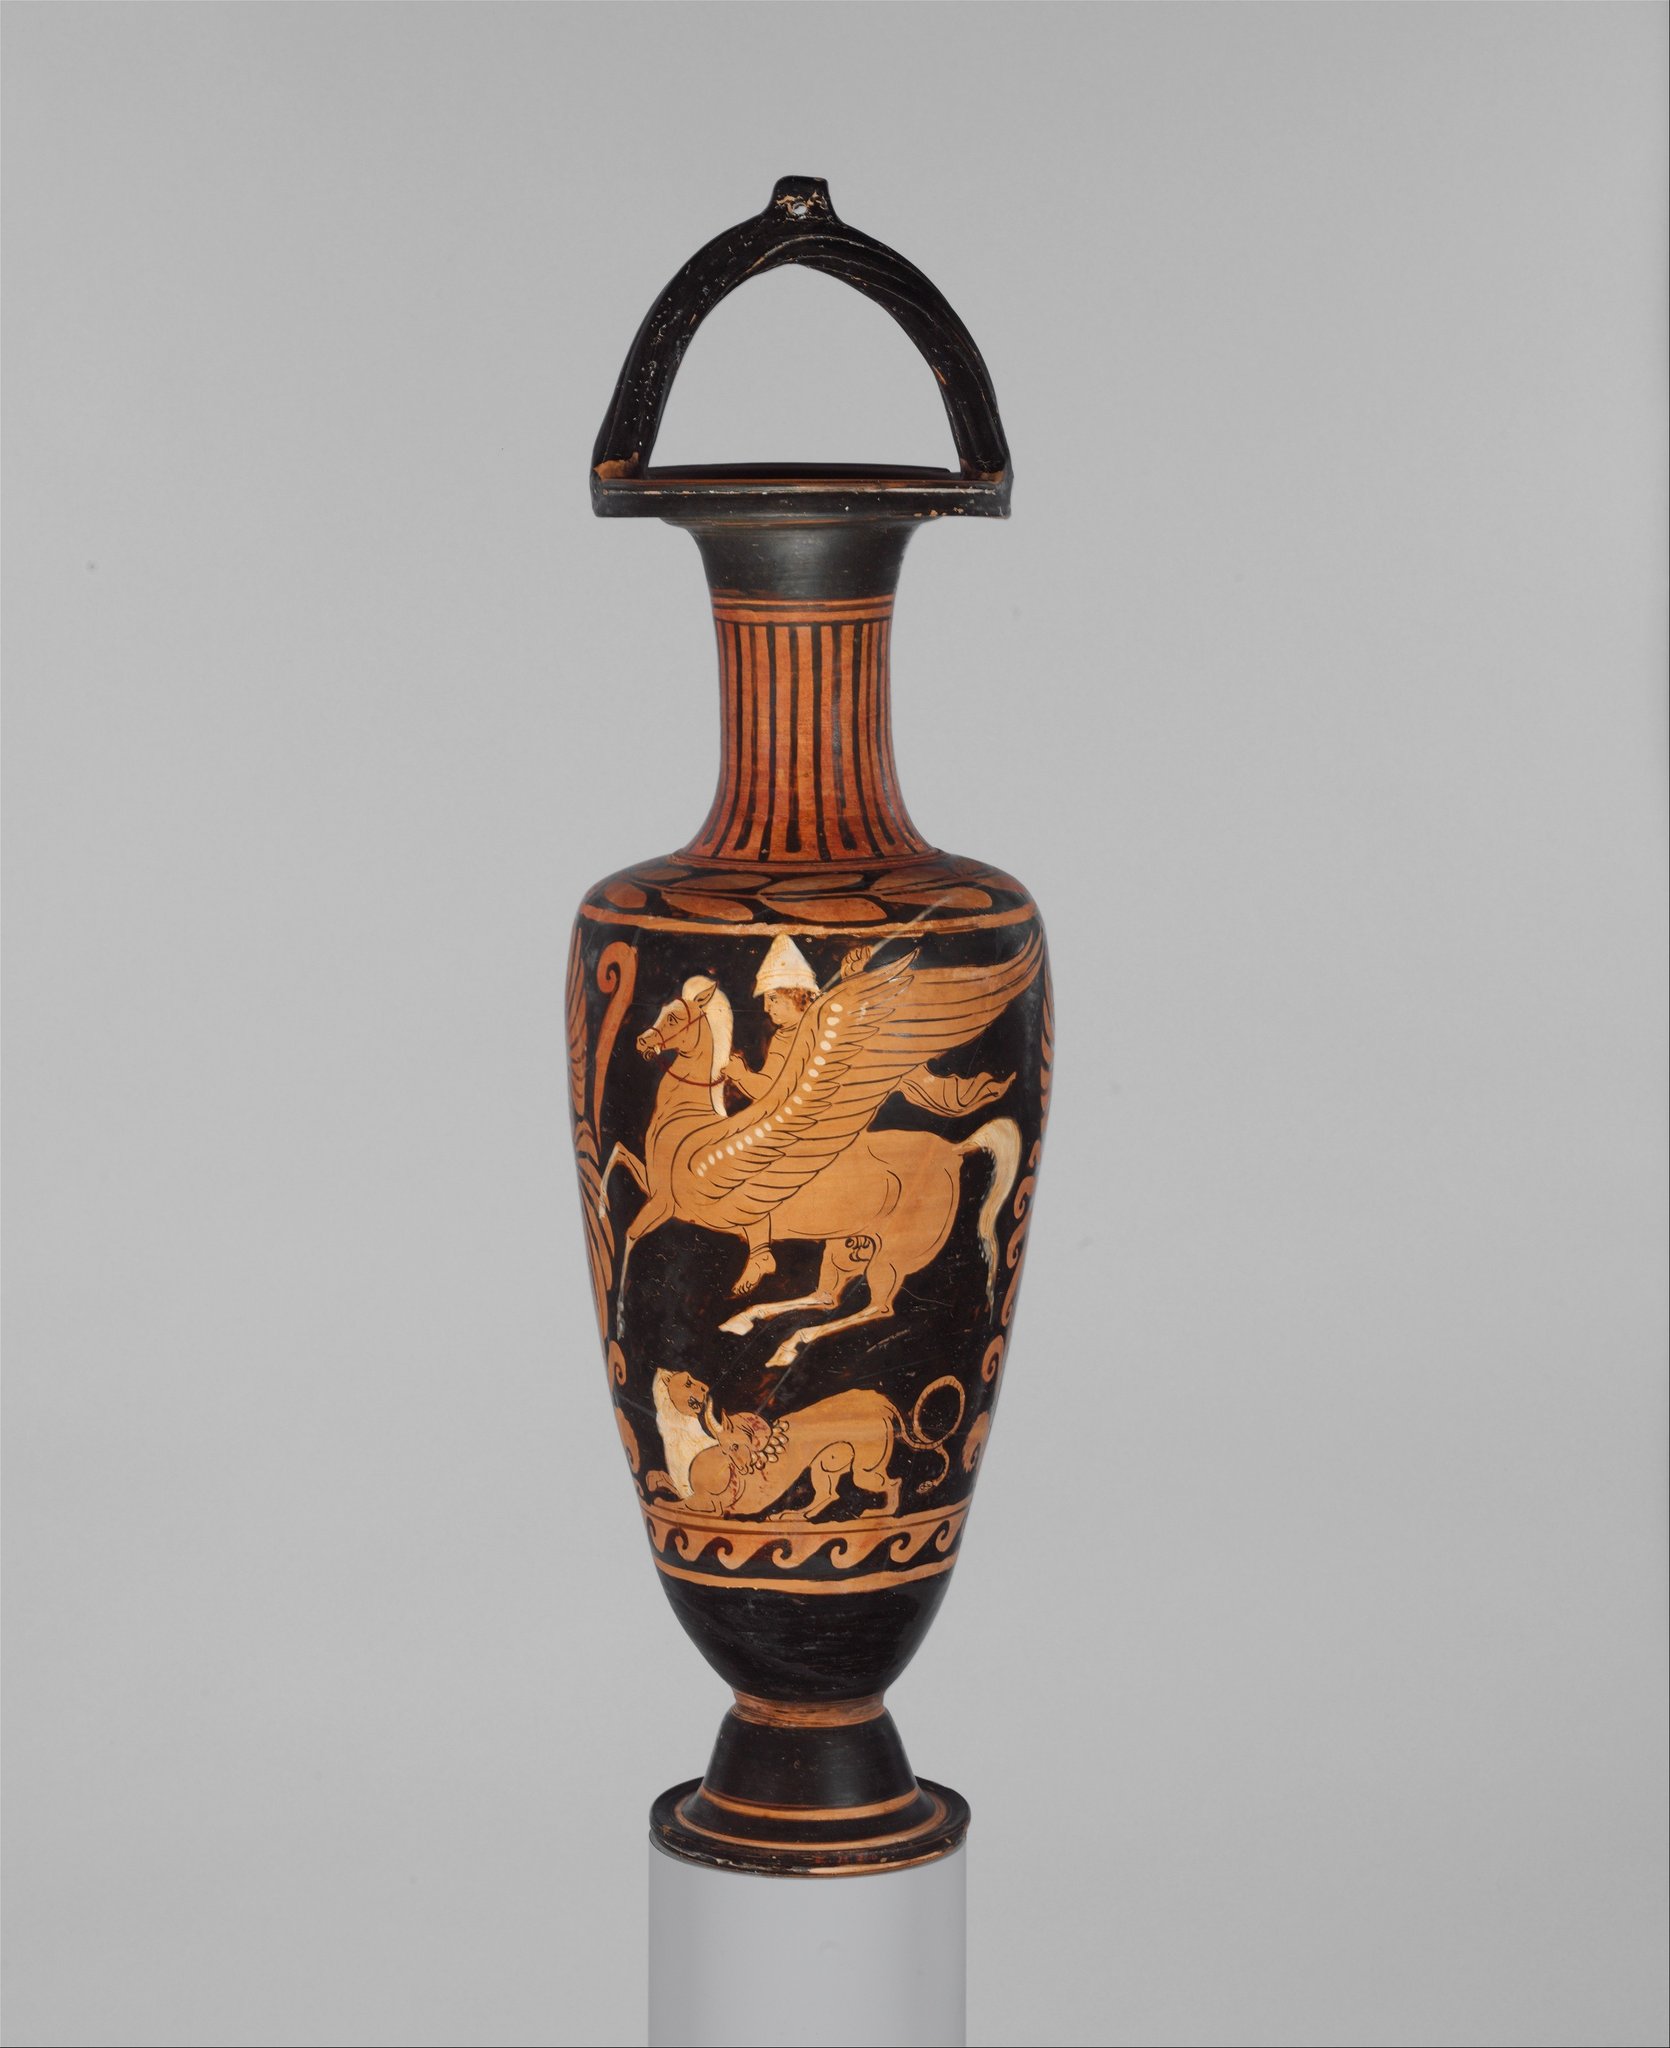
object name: bail amphora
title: Terracotta bail-amphora (jar)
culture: greek or south italian or campanian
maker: ixion painter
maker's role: artist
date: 330-310 BCE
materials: terracotta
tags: men,pegasus,lions